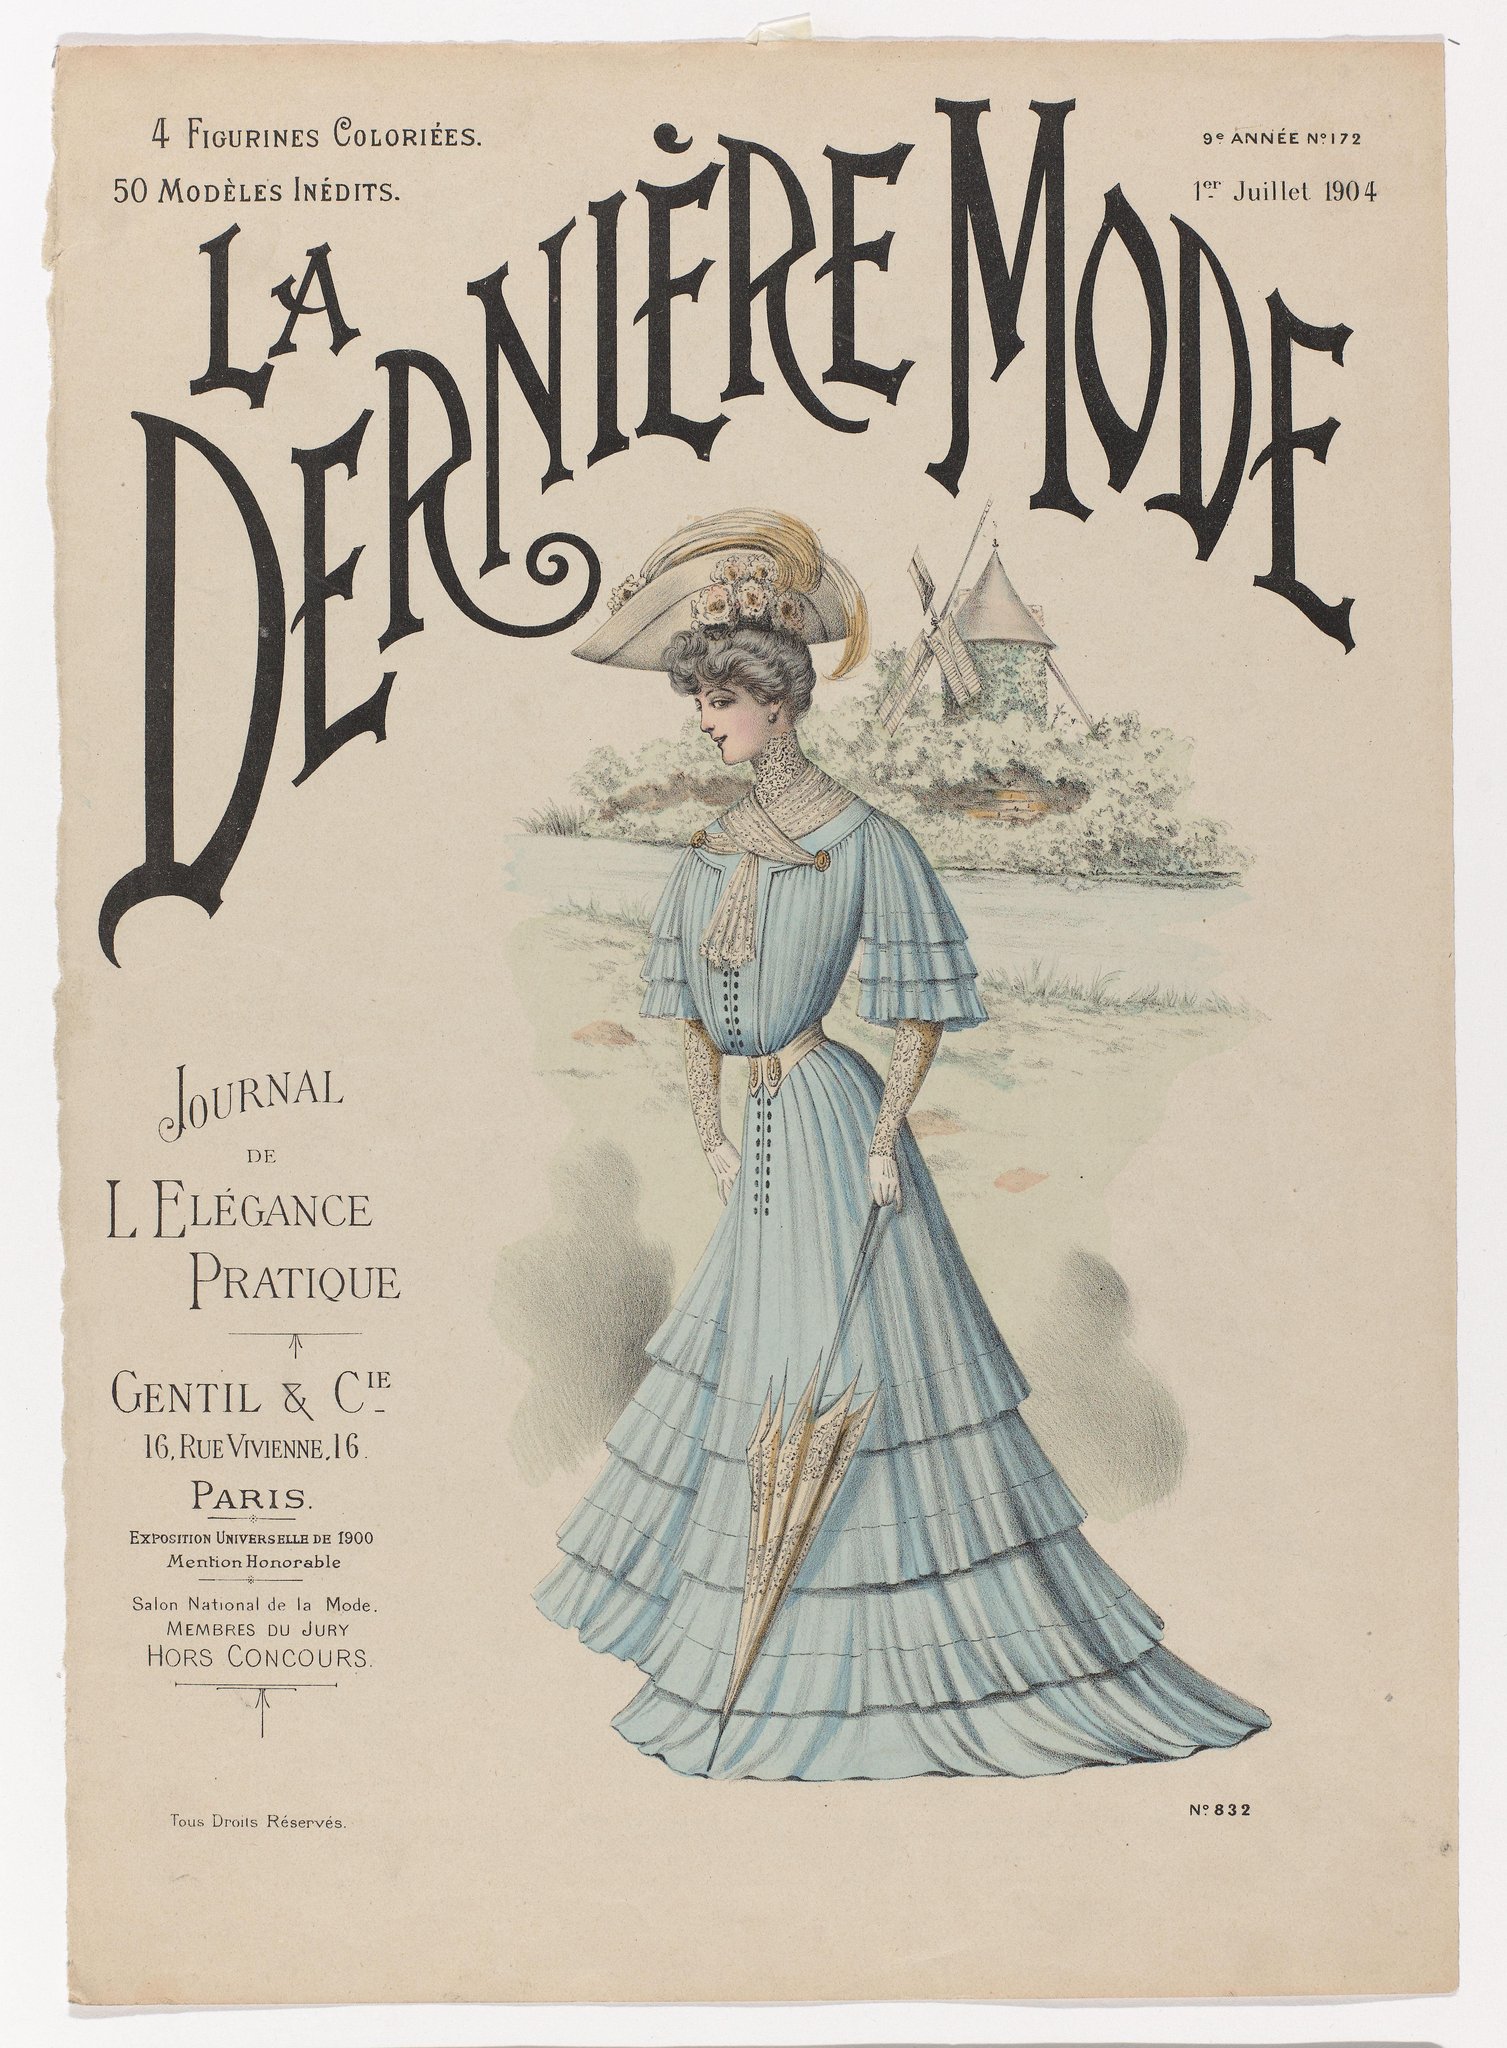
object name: fashion print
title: The Fashion Magazine as Temptress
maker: Anonymous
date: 1904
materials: paper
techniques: hand coloring, lithograph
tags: walking-stick, staff, cane (+ girls' clothes), fashion plates, dress, gown (+ women's clothes), windmill in landscape, belt, girdle, waistband (+ women's clothes)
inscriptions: title: ‘La Dernière mode. / Edition de luxe. / Paraissant deux fois par mois...’, inscription: ‘4 FIGURINES COLORIÉES. / 50 MODLES INÉDITS.’, address: ‘GENTIL & CIE / 16 , RUE VIVIENNE, 16. / PARIS. / EXPOSITION UNIVERSELLE DE 1900 / Mention Honorable / Salon National de la Mode. / MEMBRES DU JURY / HORS CONCOURS/ Tous Droits Réservés.’, title: ‘LA DERNIÈRE MODE / JOURNAL DE L ELÉGANCE PRATIQUE’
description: The first fashion magazines were sold only by subscription. They have nondescript covers, with neither text nor image. This changed at the end of the 19th century when the publications came to be displayed in stands and shops. Publishers went to great lengths to entice potential buyers by means of attractive covers.